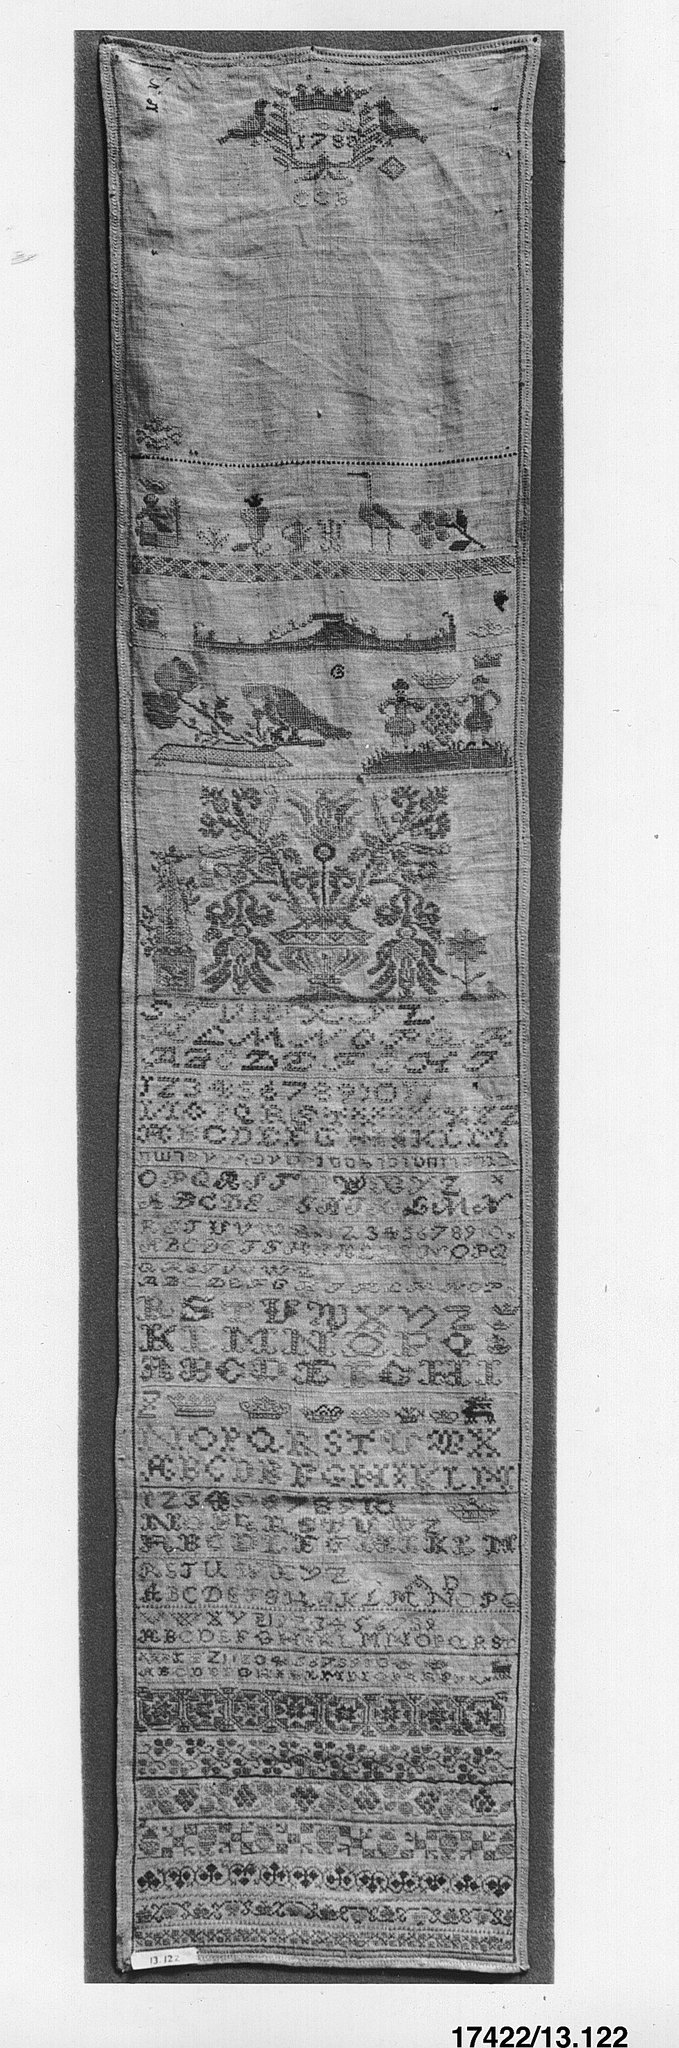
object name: sampler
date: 1782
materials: canvas, silk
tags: birds,flowers,coat of arms